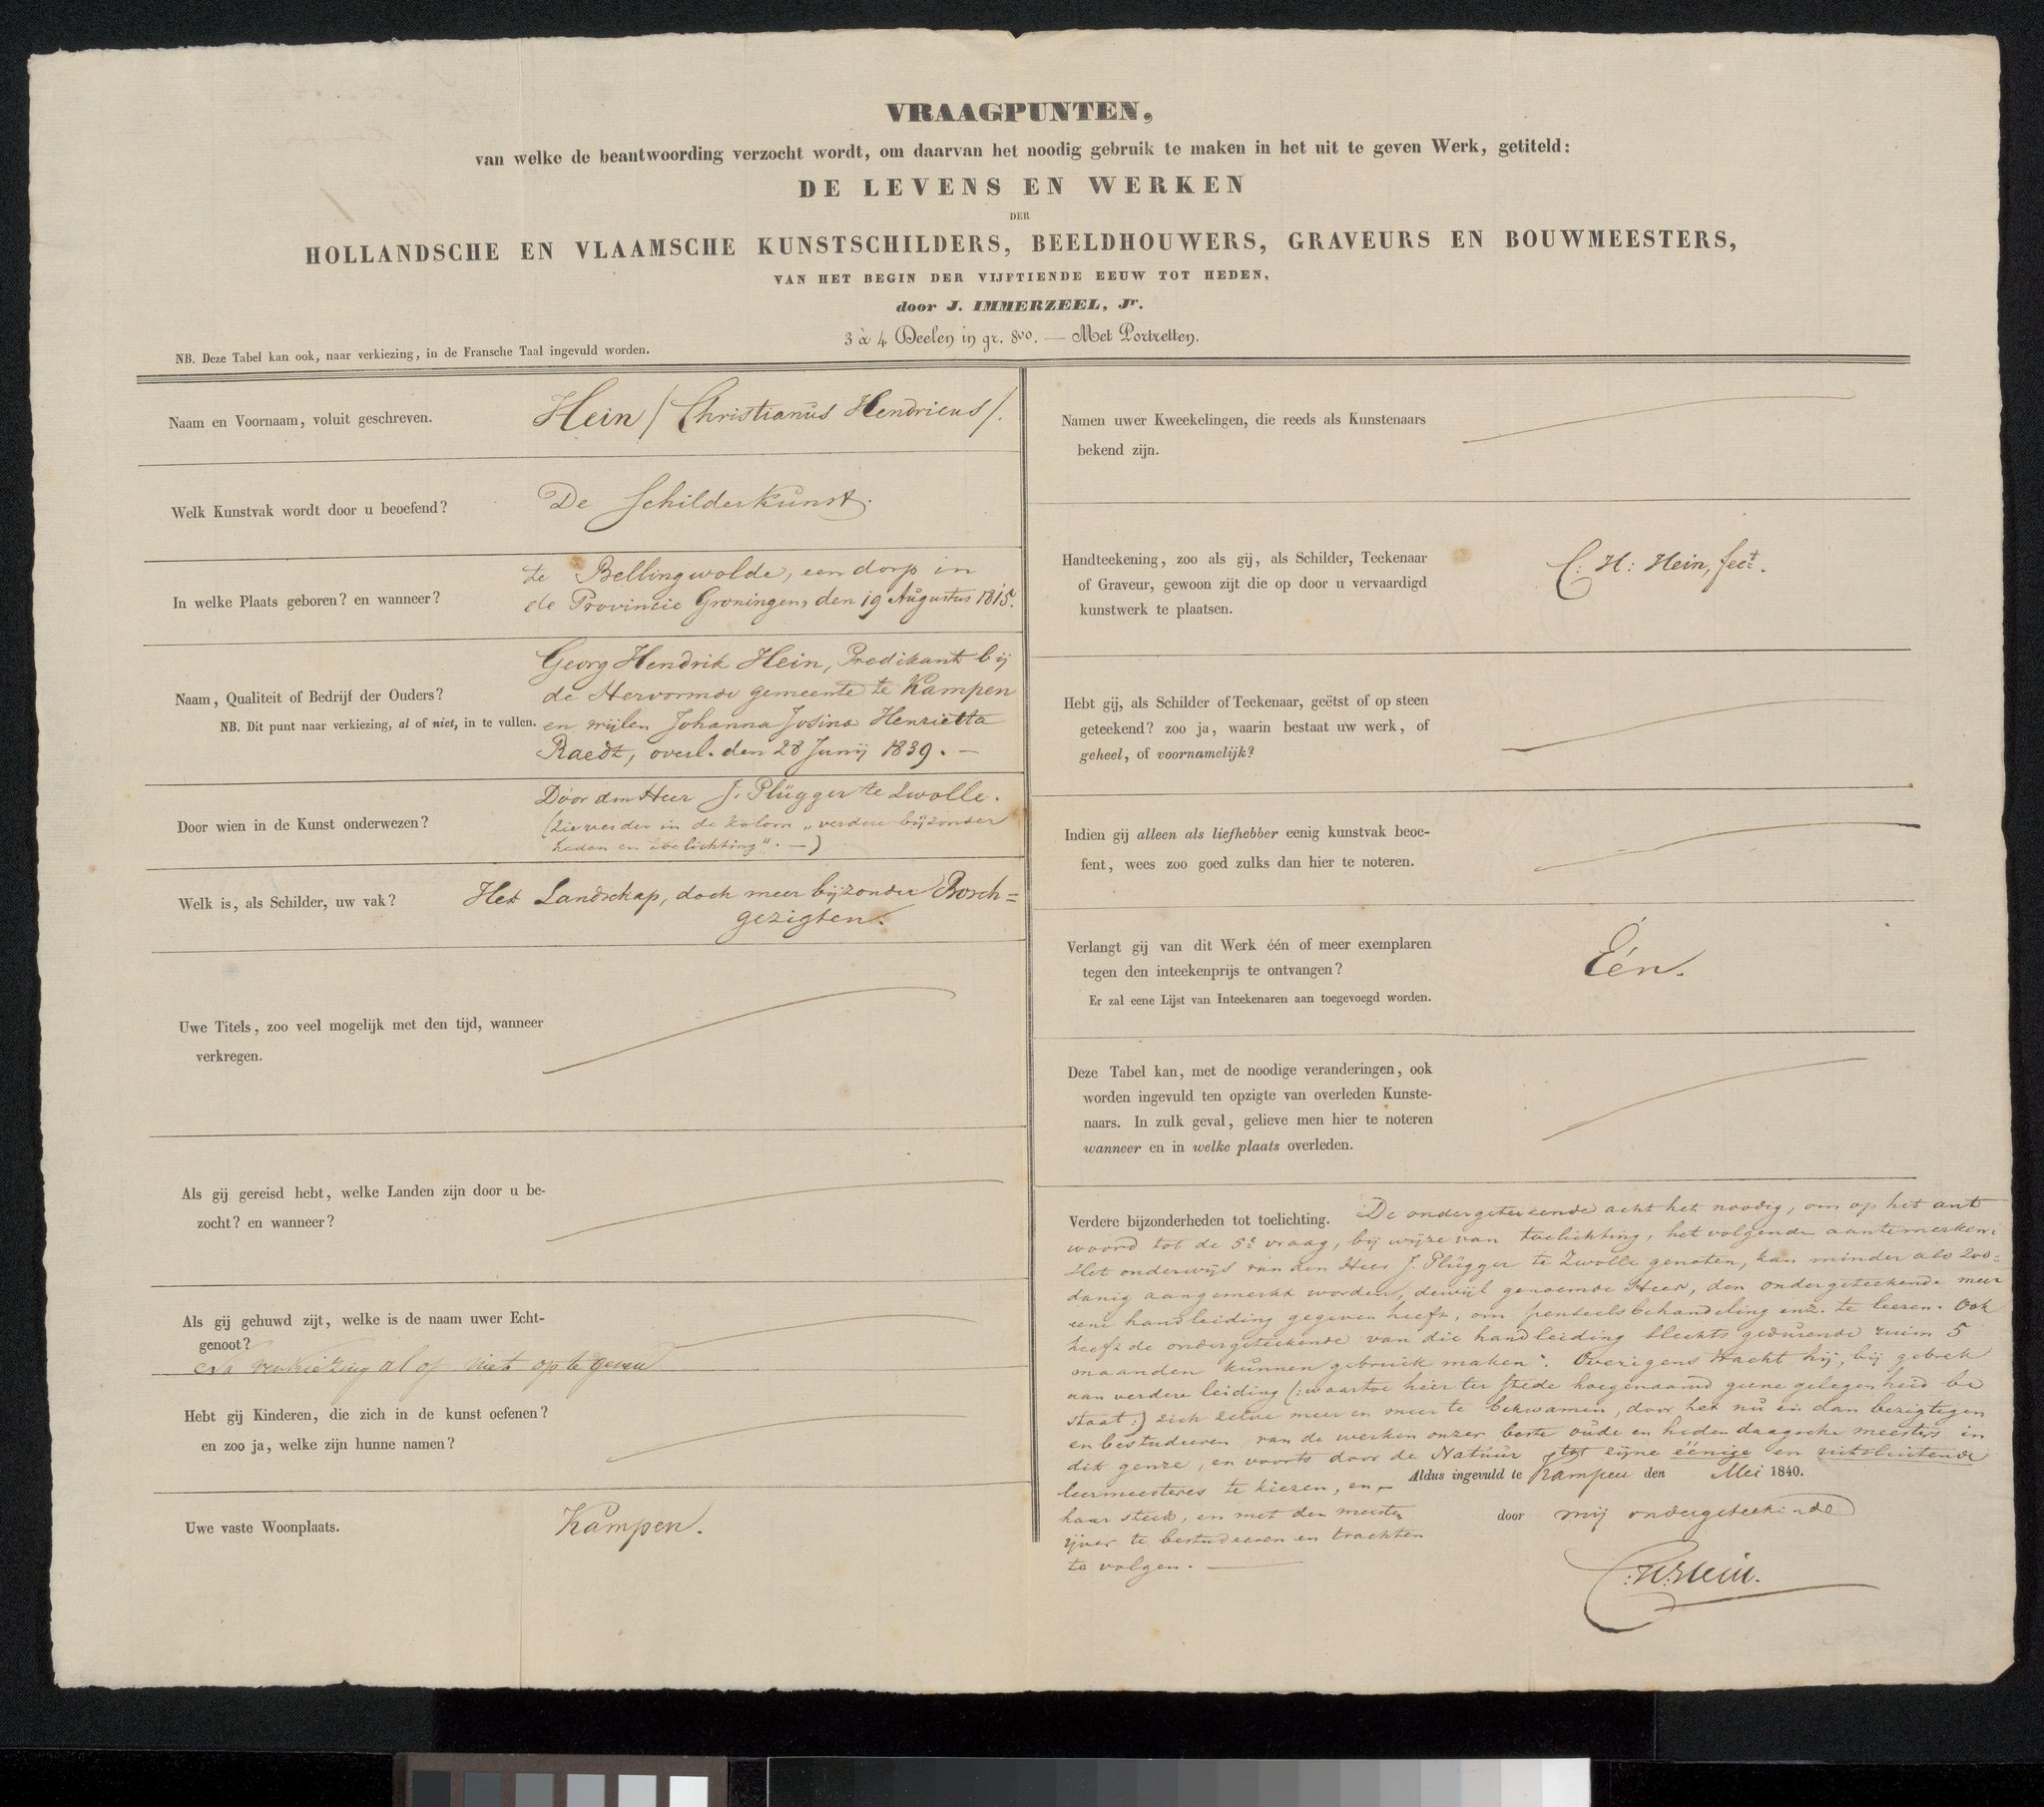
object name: manuscript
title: Enquêteformulier ingevuld door Christianus Hendricus Hein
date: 1805-1840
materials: ink, paper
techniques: pen, printing, writing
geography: kampen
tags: print maker, draughtsman, christianus hendricus hein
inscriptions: watermark, inscription: ‘Vraagpunten,/ van welke de beantwoording verzocht wordt, om daarvan het noodig gebruik te maken in het uit te geven Werk, getiteld: De levens en werken/ der Hollandsche en Vlaamsche kunstschilders, beeldhouwers,/ graveurs en bouwmeesters, van het begin der vijftiende eeuw tot heden/ door J. Immerzeel, Jr.’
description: Opgenomen in: Immerzeel, J. Jr., De levens en werken der Hollandsche en Vlaamsche kunstschilders, beeldhouwers, graveurs en bouwmeesters, van het begin der vijftiende eeuw tot heden, Amsterdam: J.C. van Kesteren, 1842-1843.